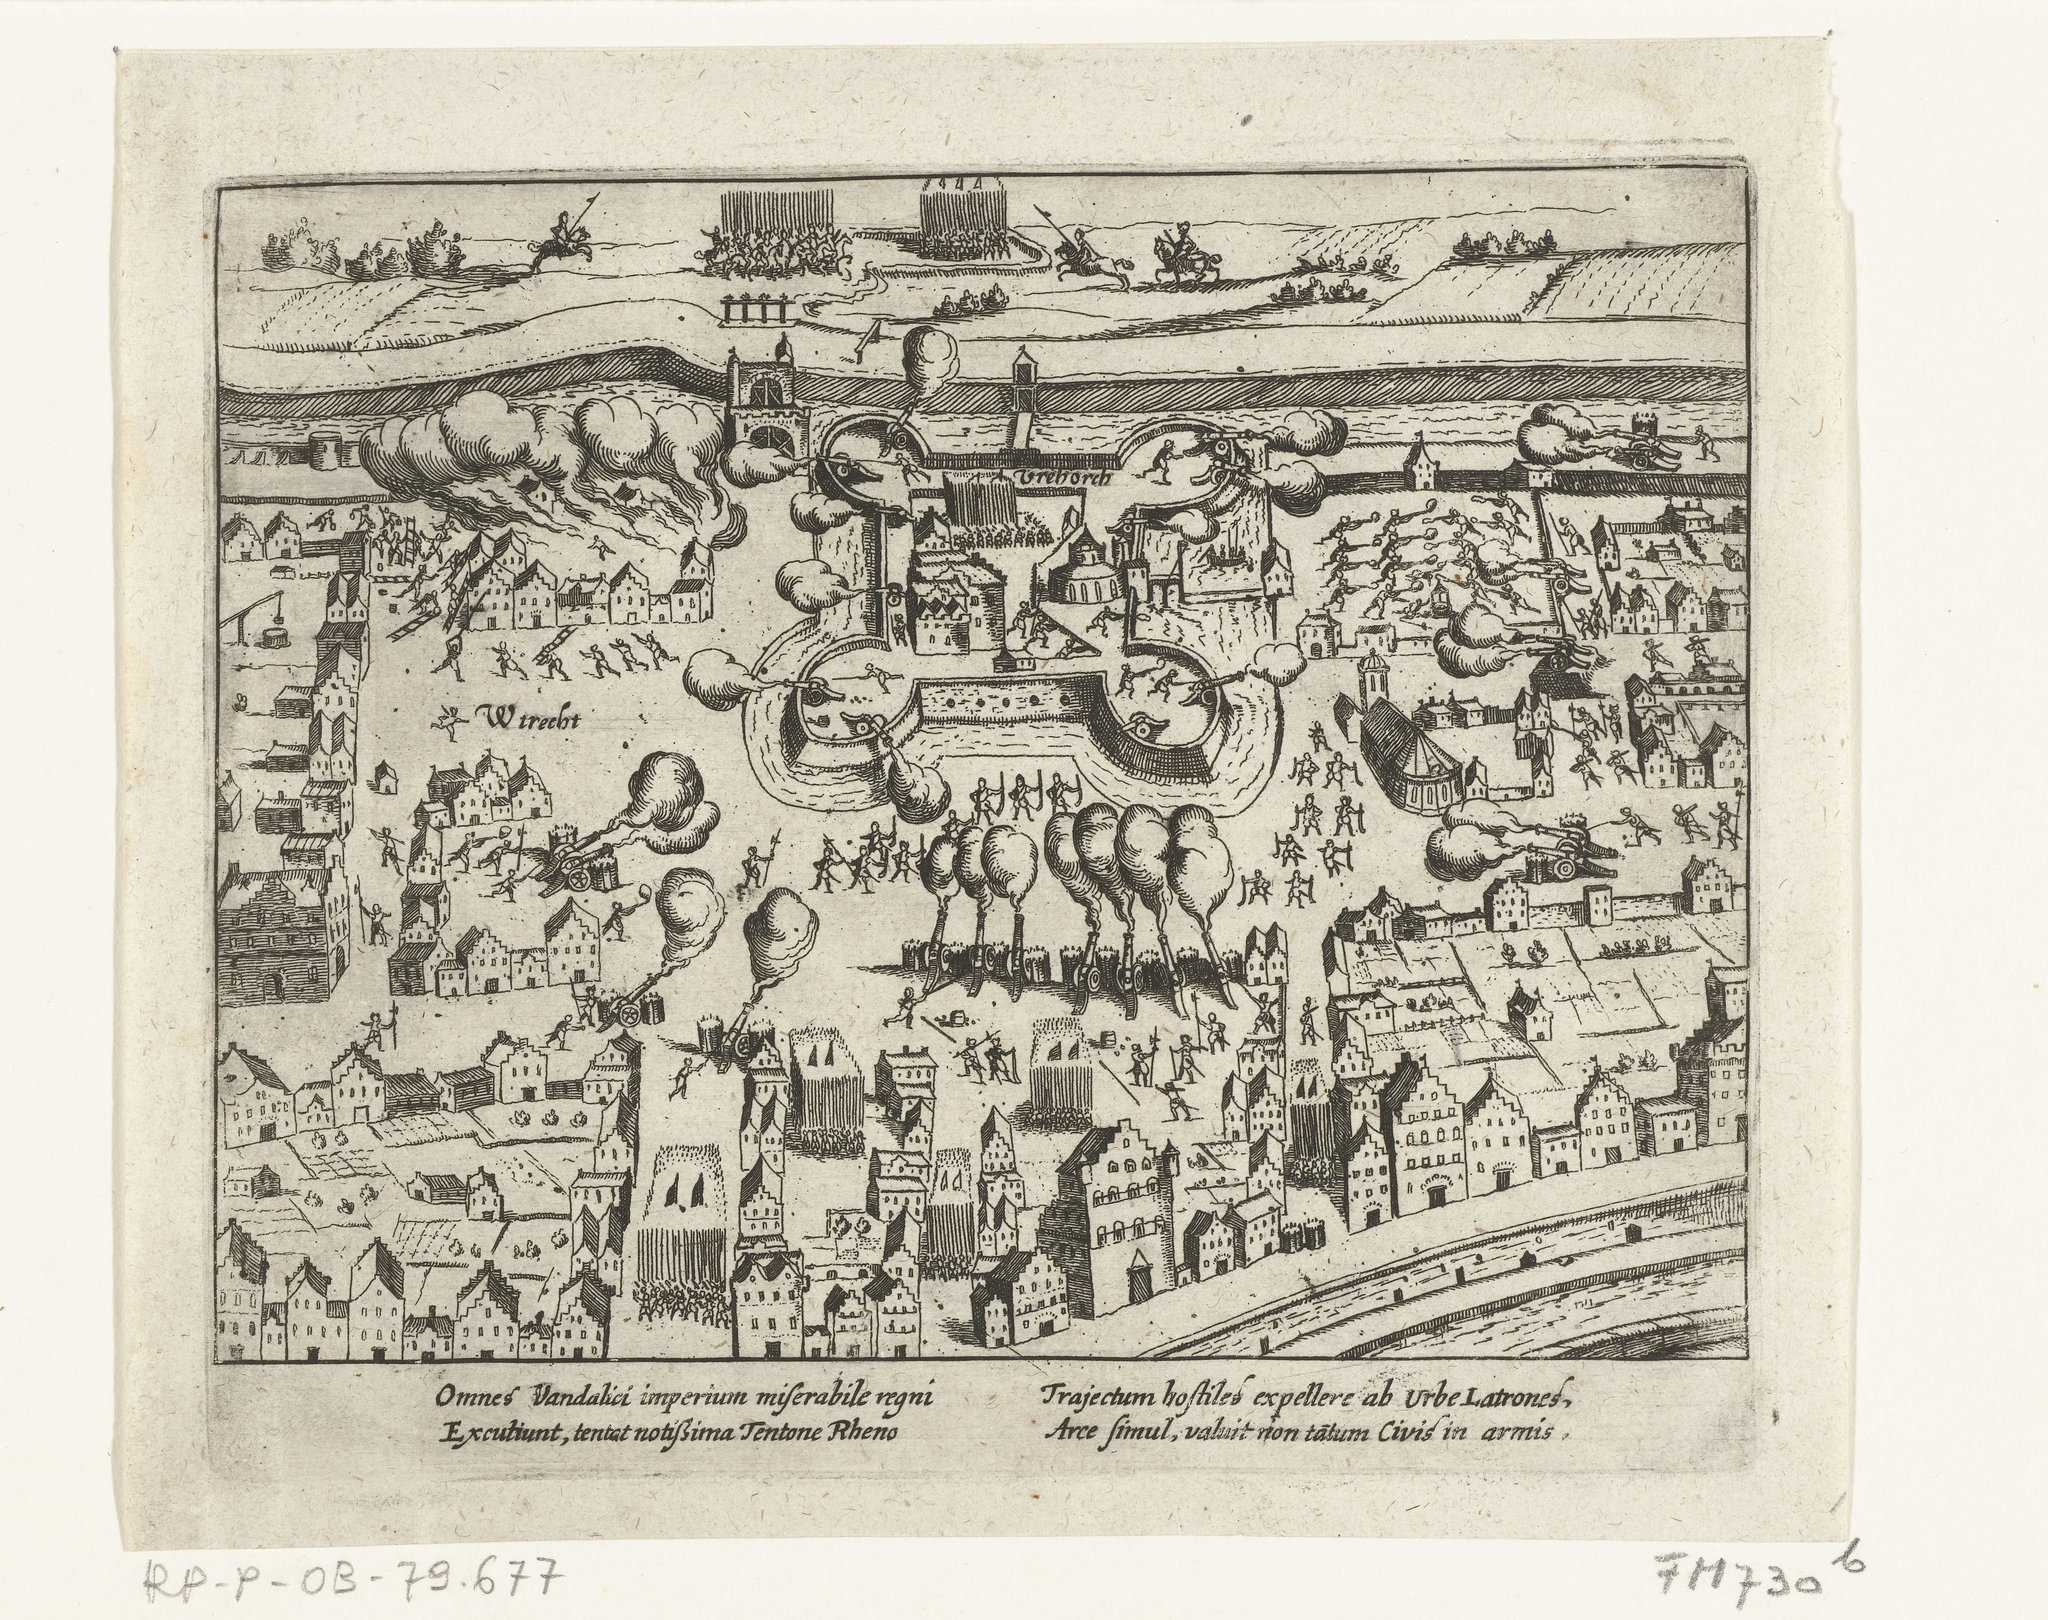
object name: print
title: Beleg van Vredenburg, 1577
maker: simon frisius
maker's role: print maker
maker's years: 1570-1628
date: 1613-1615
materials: paper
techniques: pen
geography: northern netherlands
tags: siege, position war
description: Beleg en inname van het slot Vredenburg te Utrecht door het Staatse leger onder bevel van Bossu, 11 februari 1577. Gezicht op het fort en de omliggende straten met de diverse schermutselingen. Met onderschrift van 4 regels in het Latijn. Ongenummerd en onbedrukt op achterzijde.